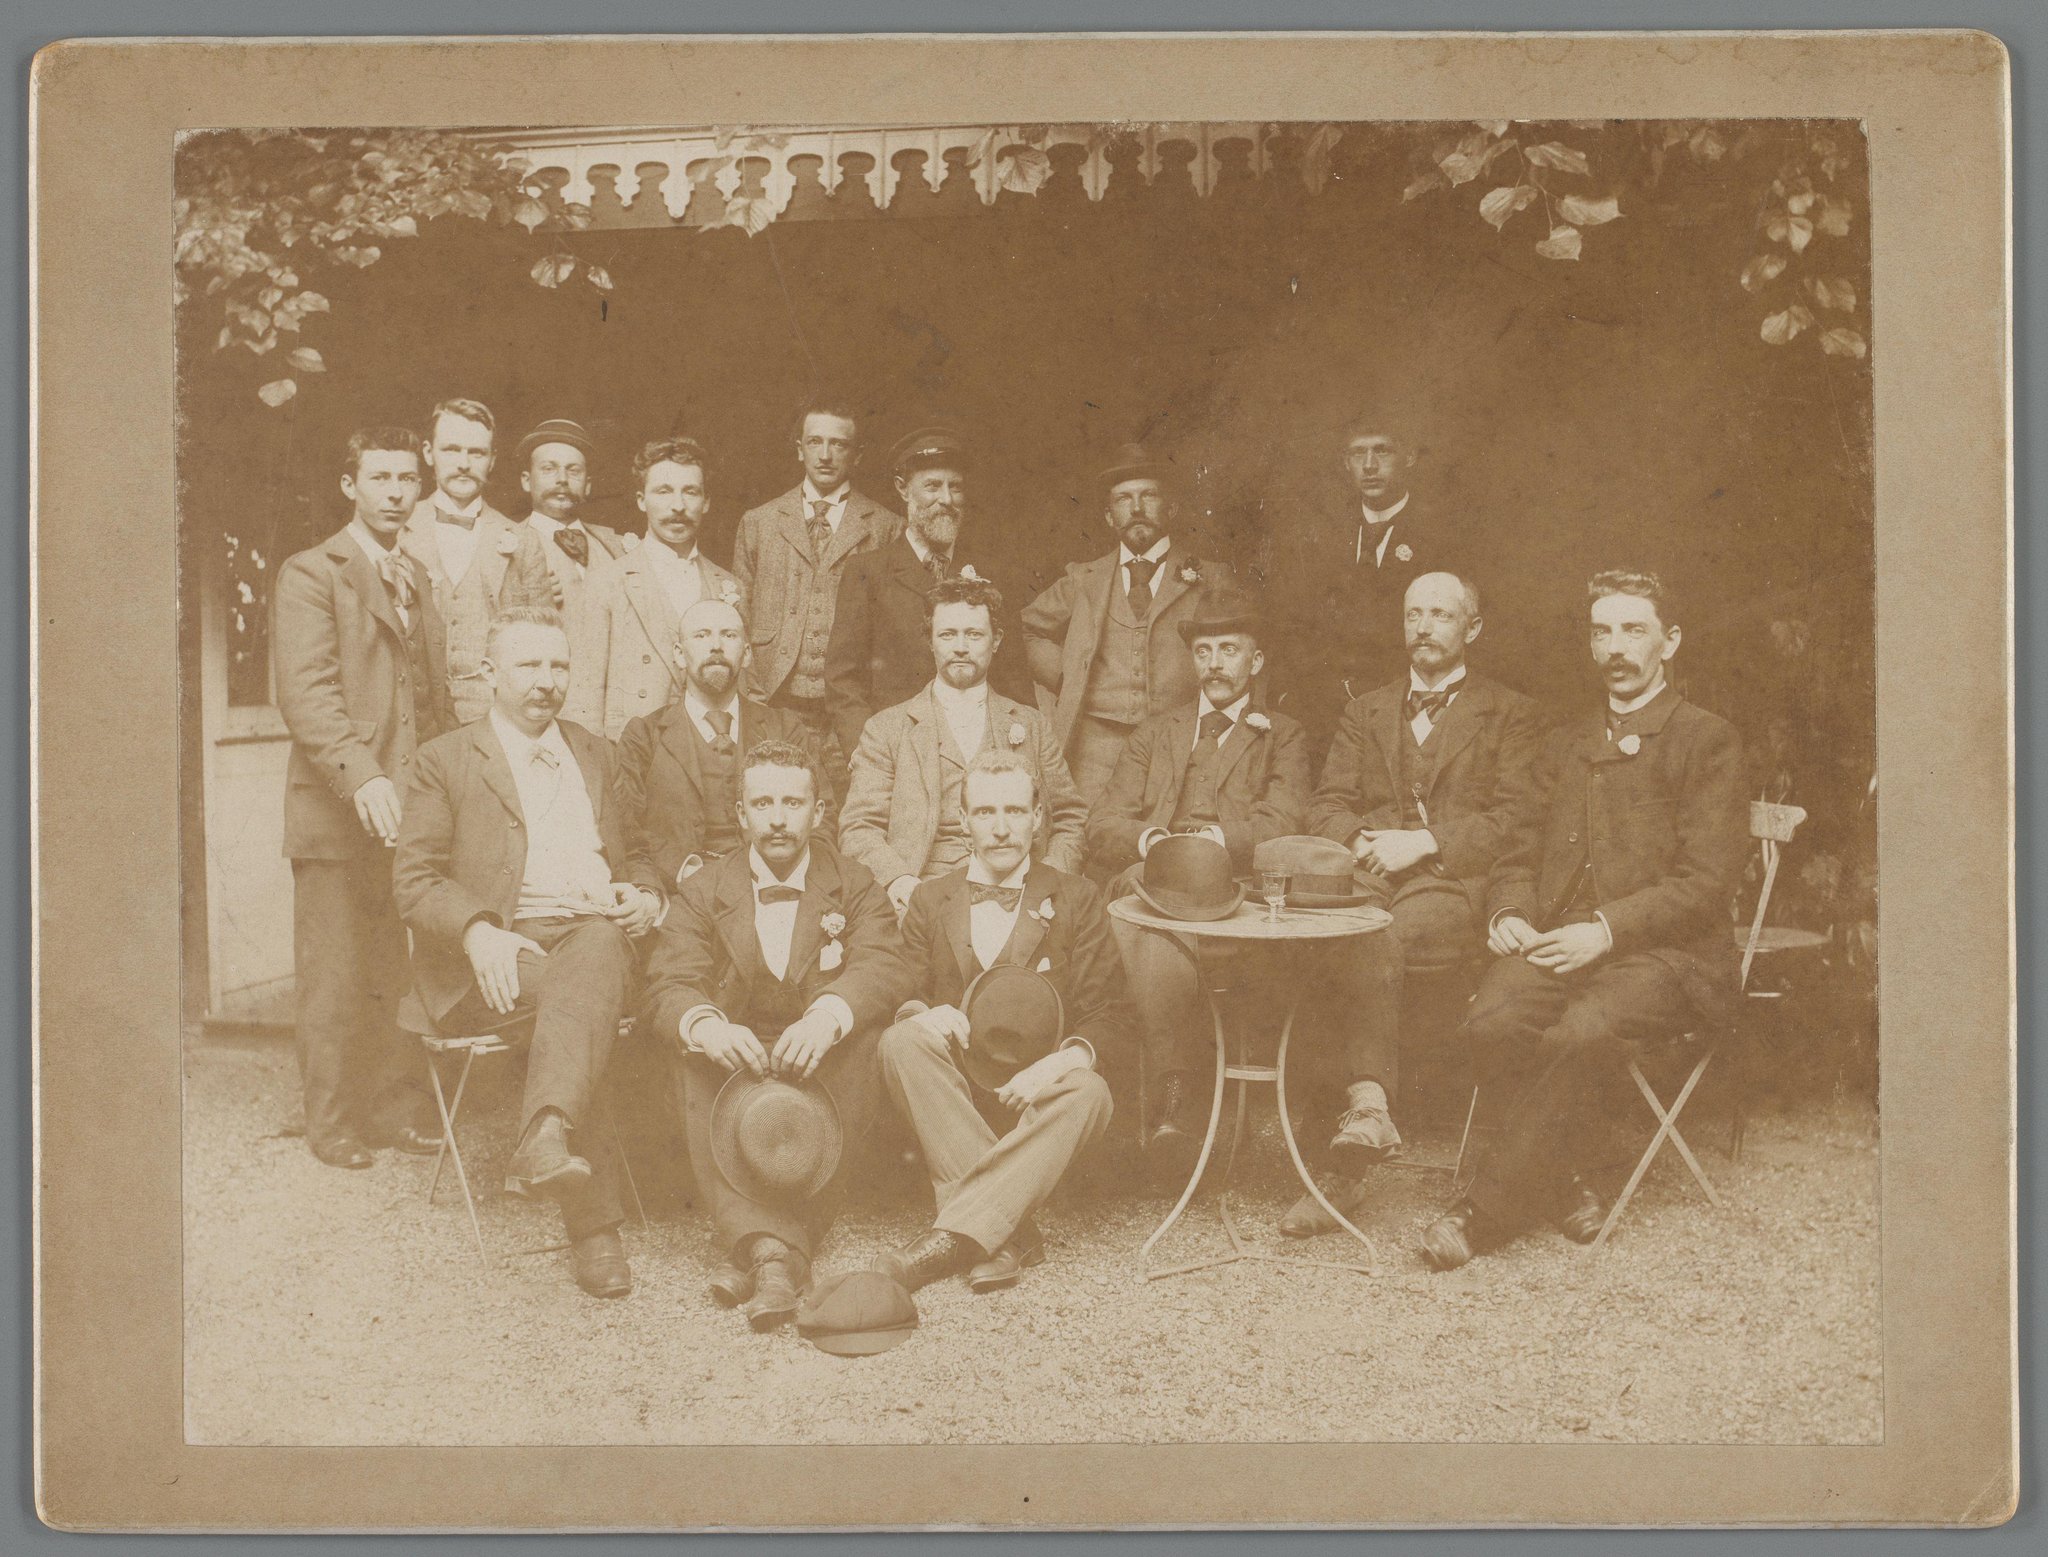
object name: photograph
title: Groepsportret van leden van het genootschap Architectura et Amicitia, met onder andere H.P. Berlage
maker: Anonymous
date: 1895-1910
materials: paper, cardboard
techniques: collodion silver print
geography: netherlands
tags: amsterdam, the hague, draughtsman, hendrik petrus berlage, architect in non-work situation, portrait, self-portrait of architect, anonymous historical persons portrayed in a group, in a group-portrait, netherlands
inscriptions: inscription: ‘foto uit archief genootschap/ Architectura et Amicitia/ (waarbij Berlage)’, initials: ‘W.K.C.’